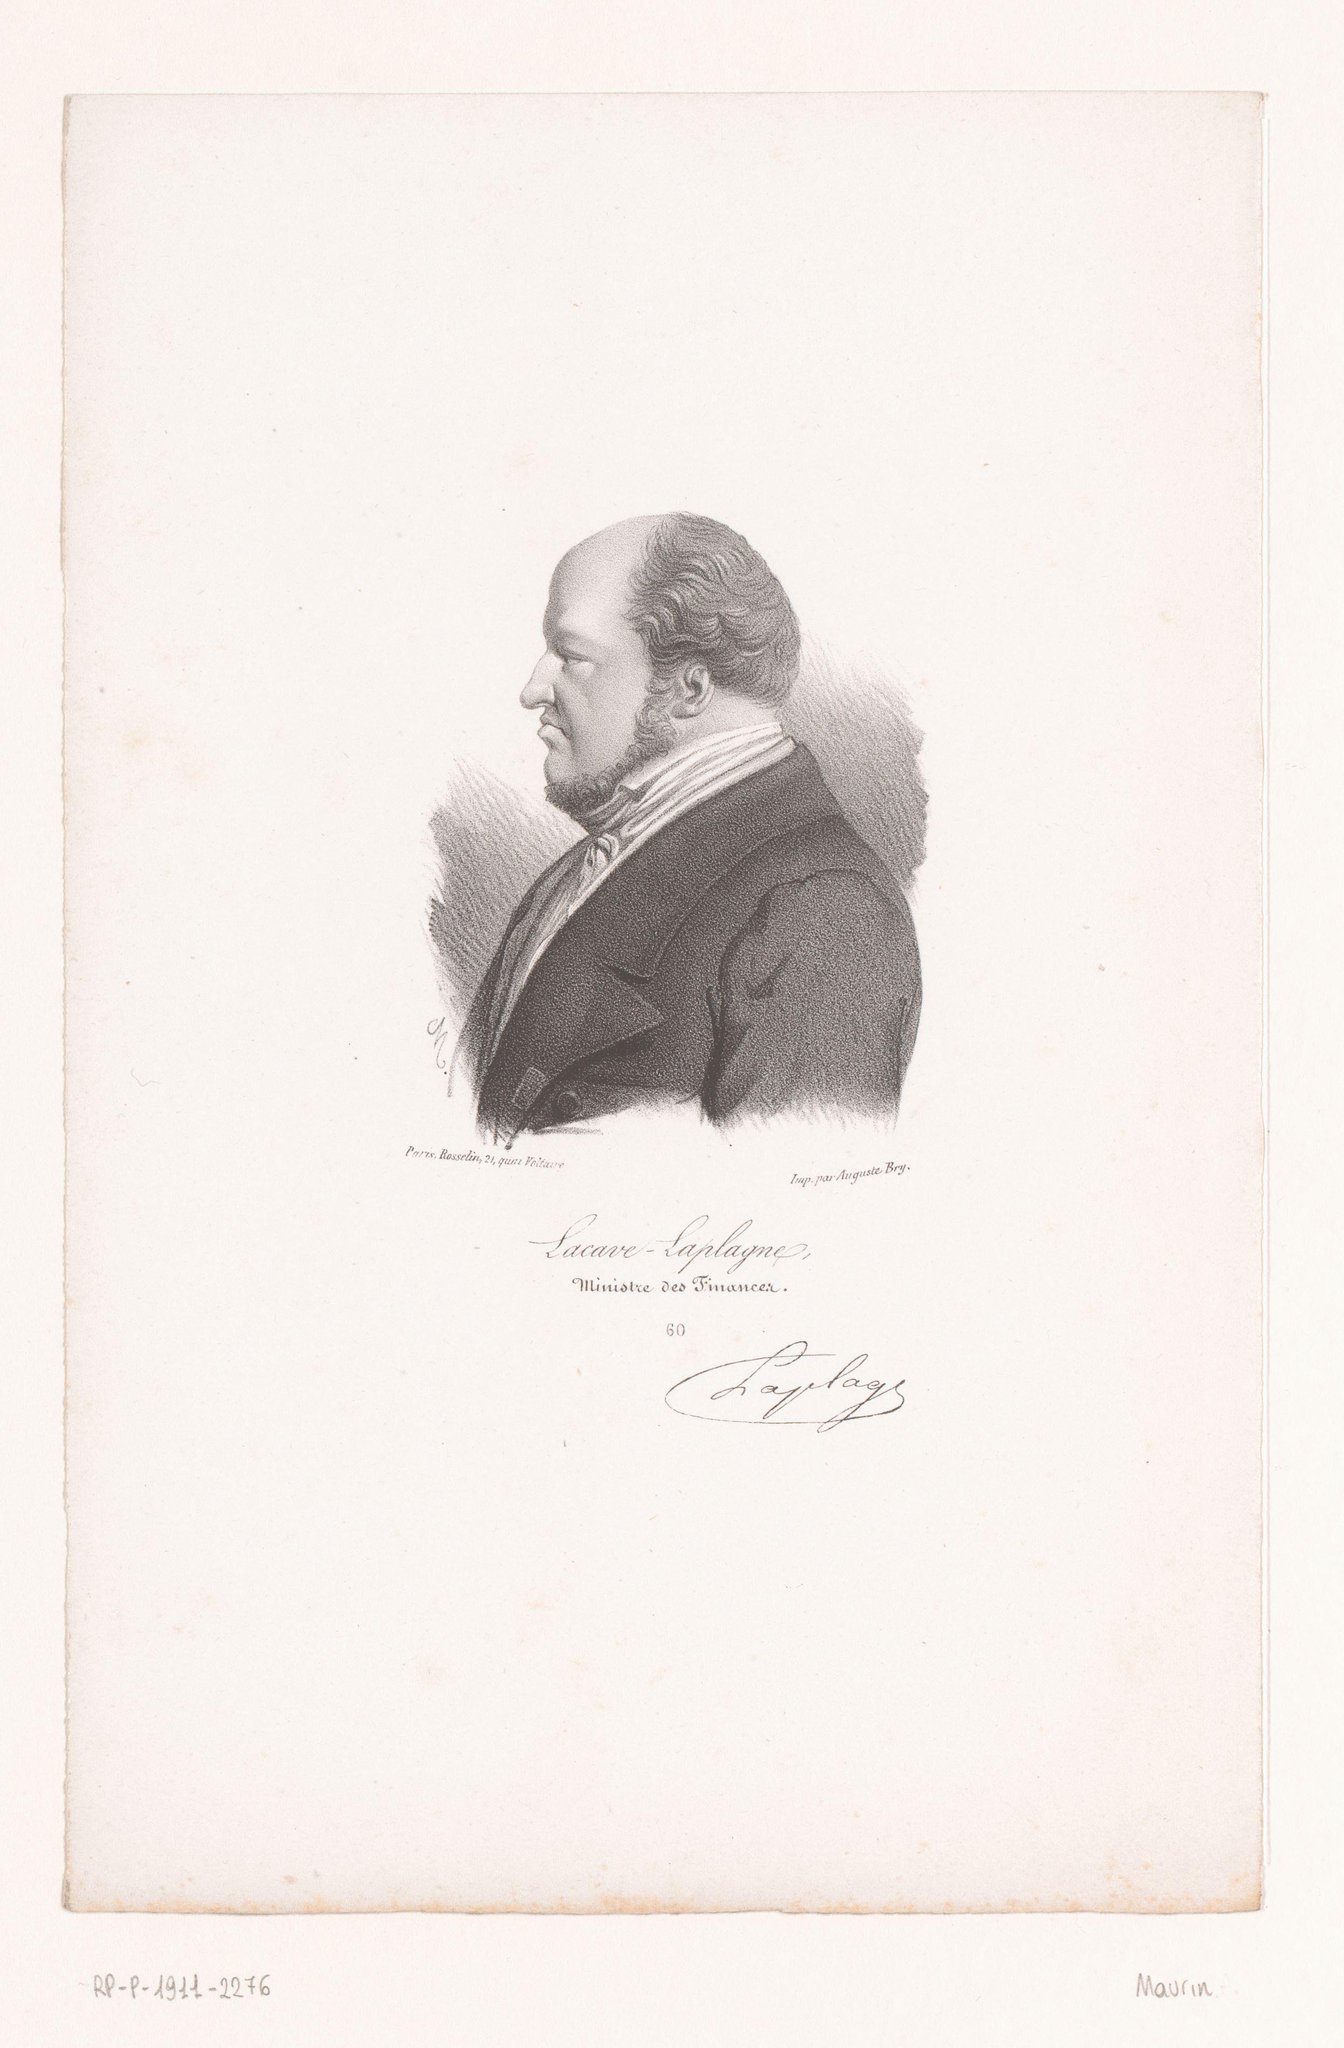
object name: print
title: Portret van Jean Lacave-Laplagne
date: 1845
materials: paper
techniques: lithograph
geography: paris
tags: paris, politician, historical persons, politician, e.g. party leader